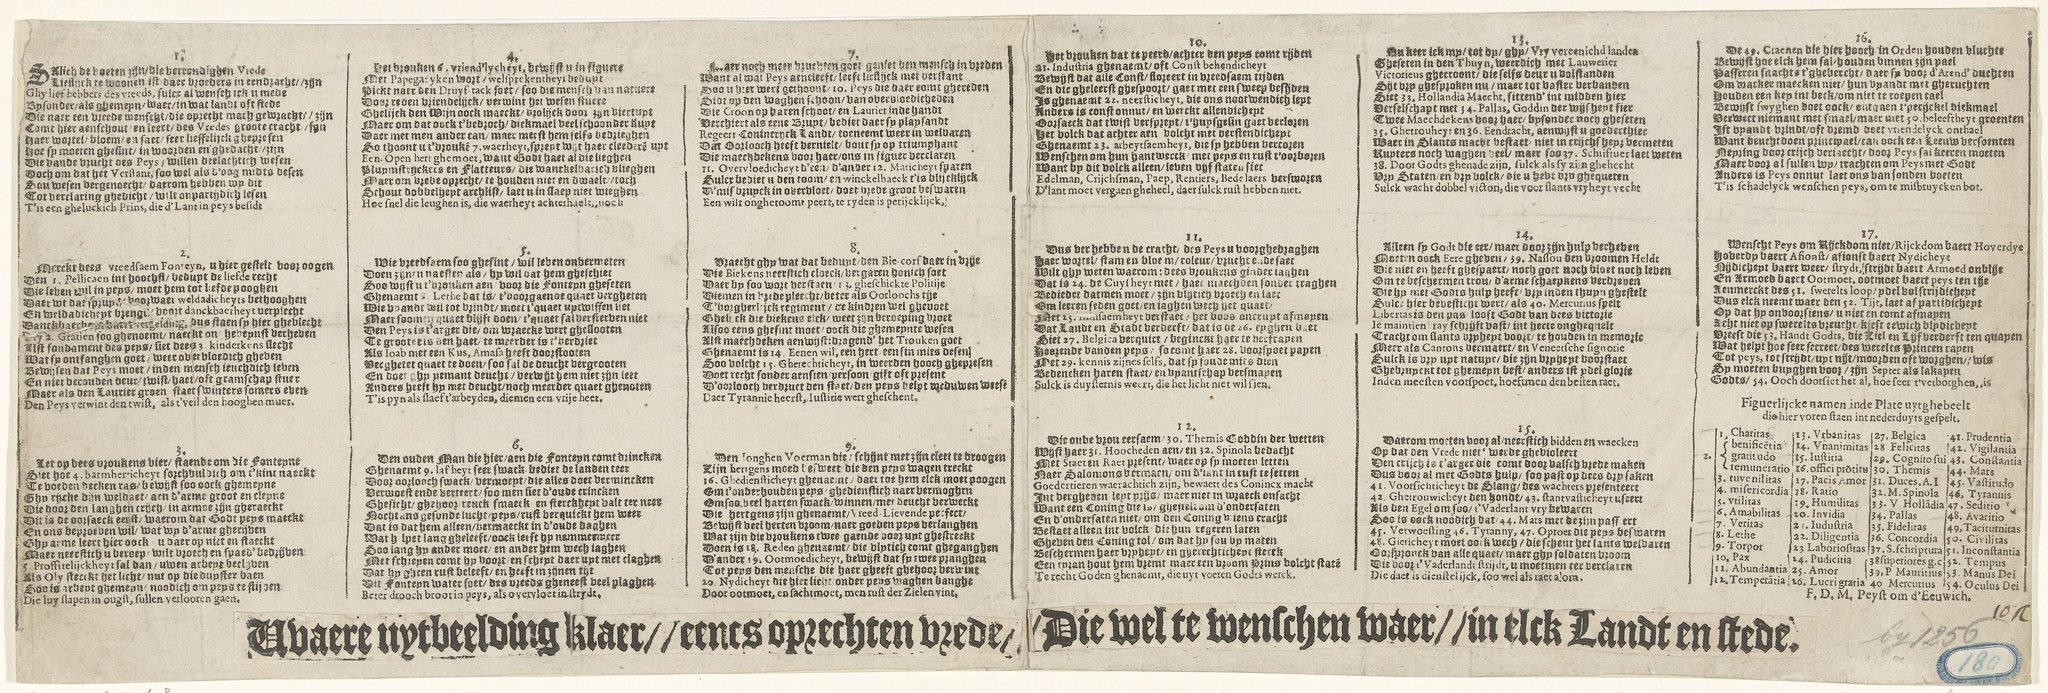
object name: text sheet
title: Waere uytbeelding klaer / eenes oprechten vrede / Die wel te wenschen waer / in elck Landt en stede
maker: d. marien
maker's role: schrijver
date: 1608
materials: paper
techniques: letterpress printing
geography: northern netherlands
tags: tachtigjarige oorlog, onderhandelingen voor het twaalfjarig bestand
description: Tekstblad behorend bij de grote allegorische voorstelling van de voorspoed die de vrede de Noordelijke en de Zuidelijke Nederlanden brengen zal, 1608. 17 genummerde verzen van elk 13 regels en de legenda 1-54 in het Nederlands. Onderaan is de uitgeknipte titel opgeplakt.